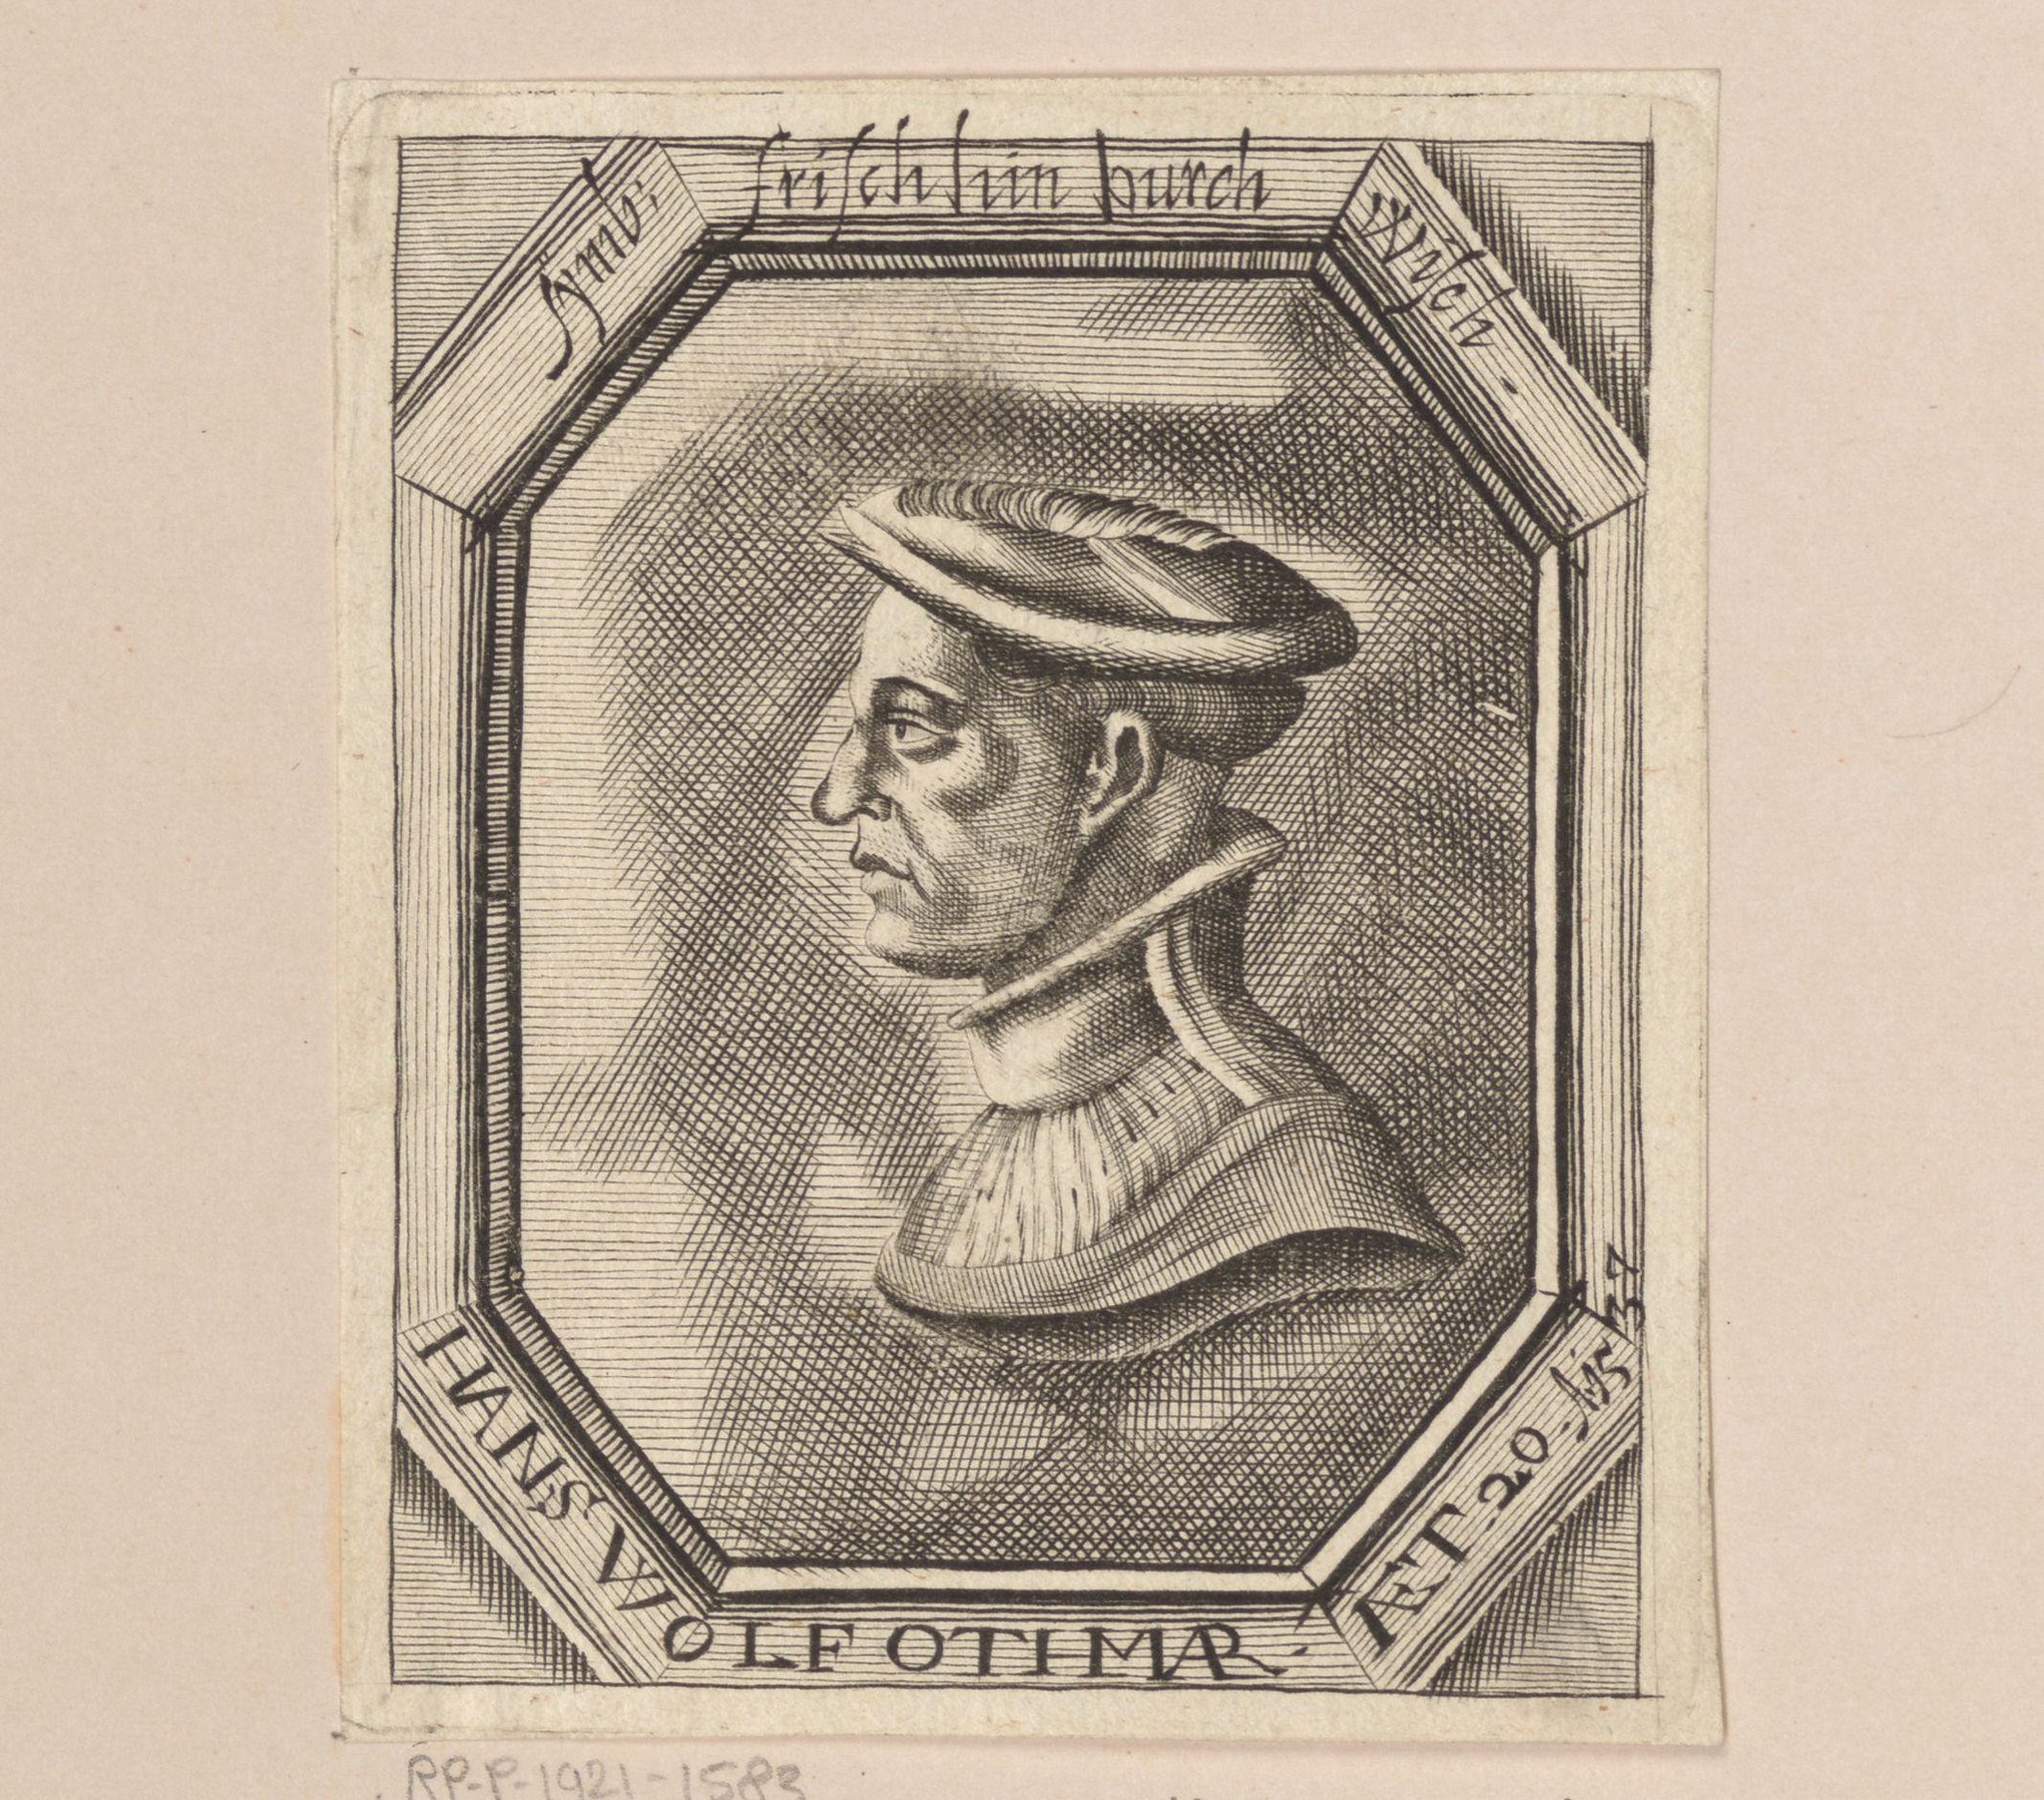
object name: print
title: Portret van Hans Wolf Othmar op 20-jarige leeftijd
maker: Anonymous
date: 1600-1699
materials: paper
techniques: engraving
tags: historical persons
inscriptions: collector's mark: Lugt 2228